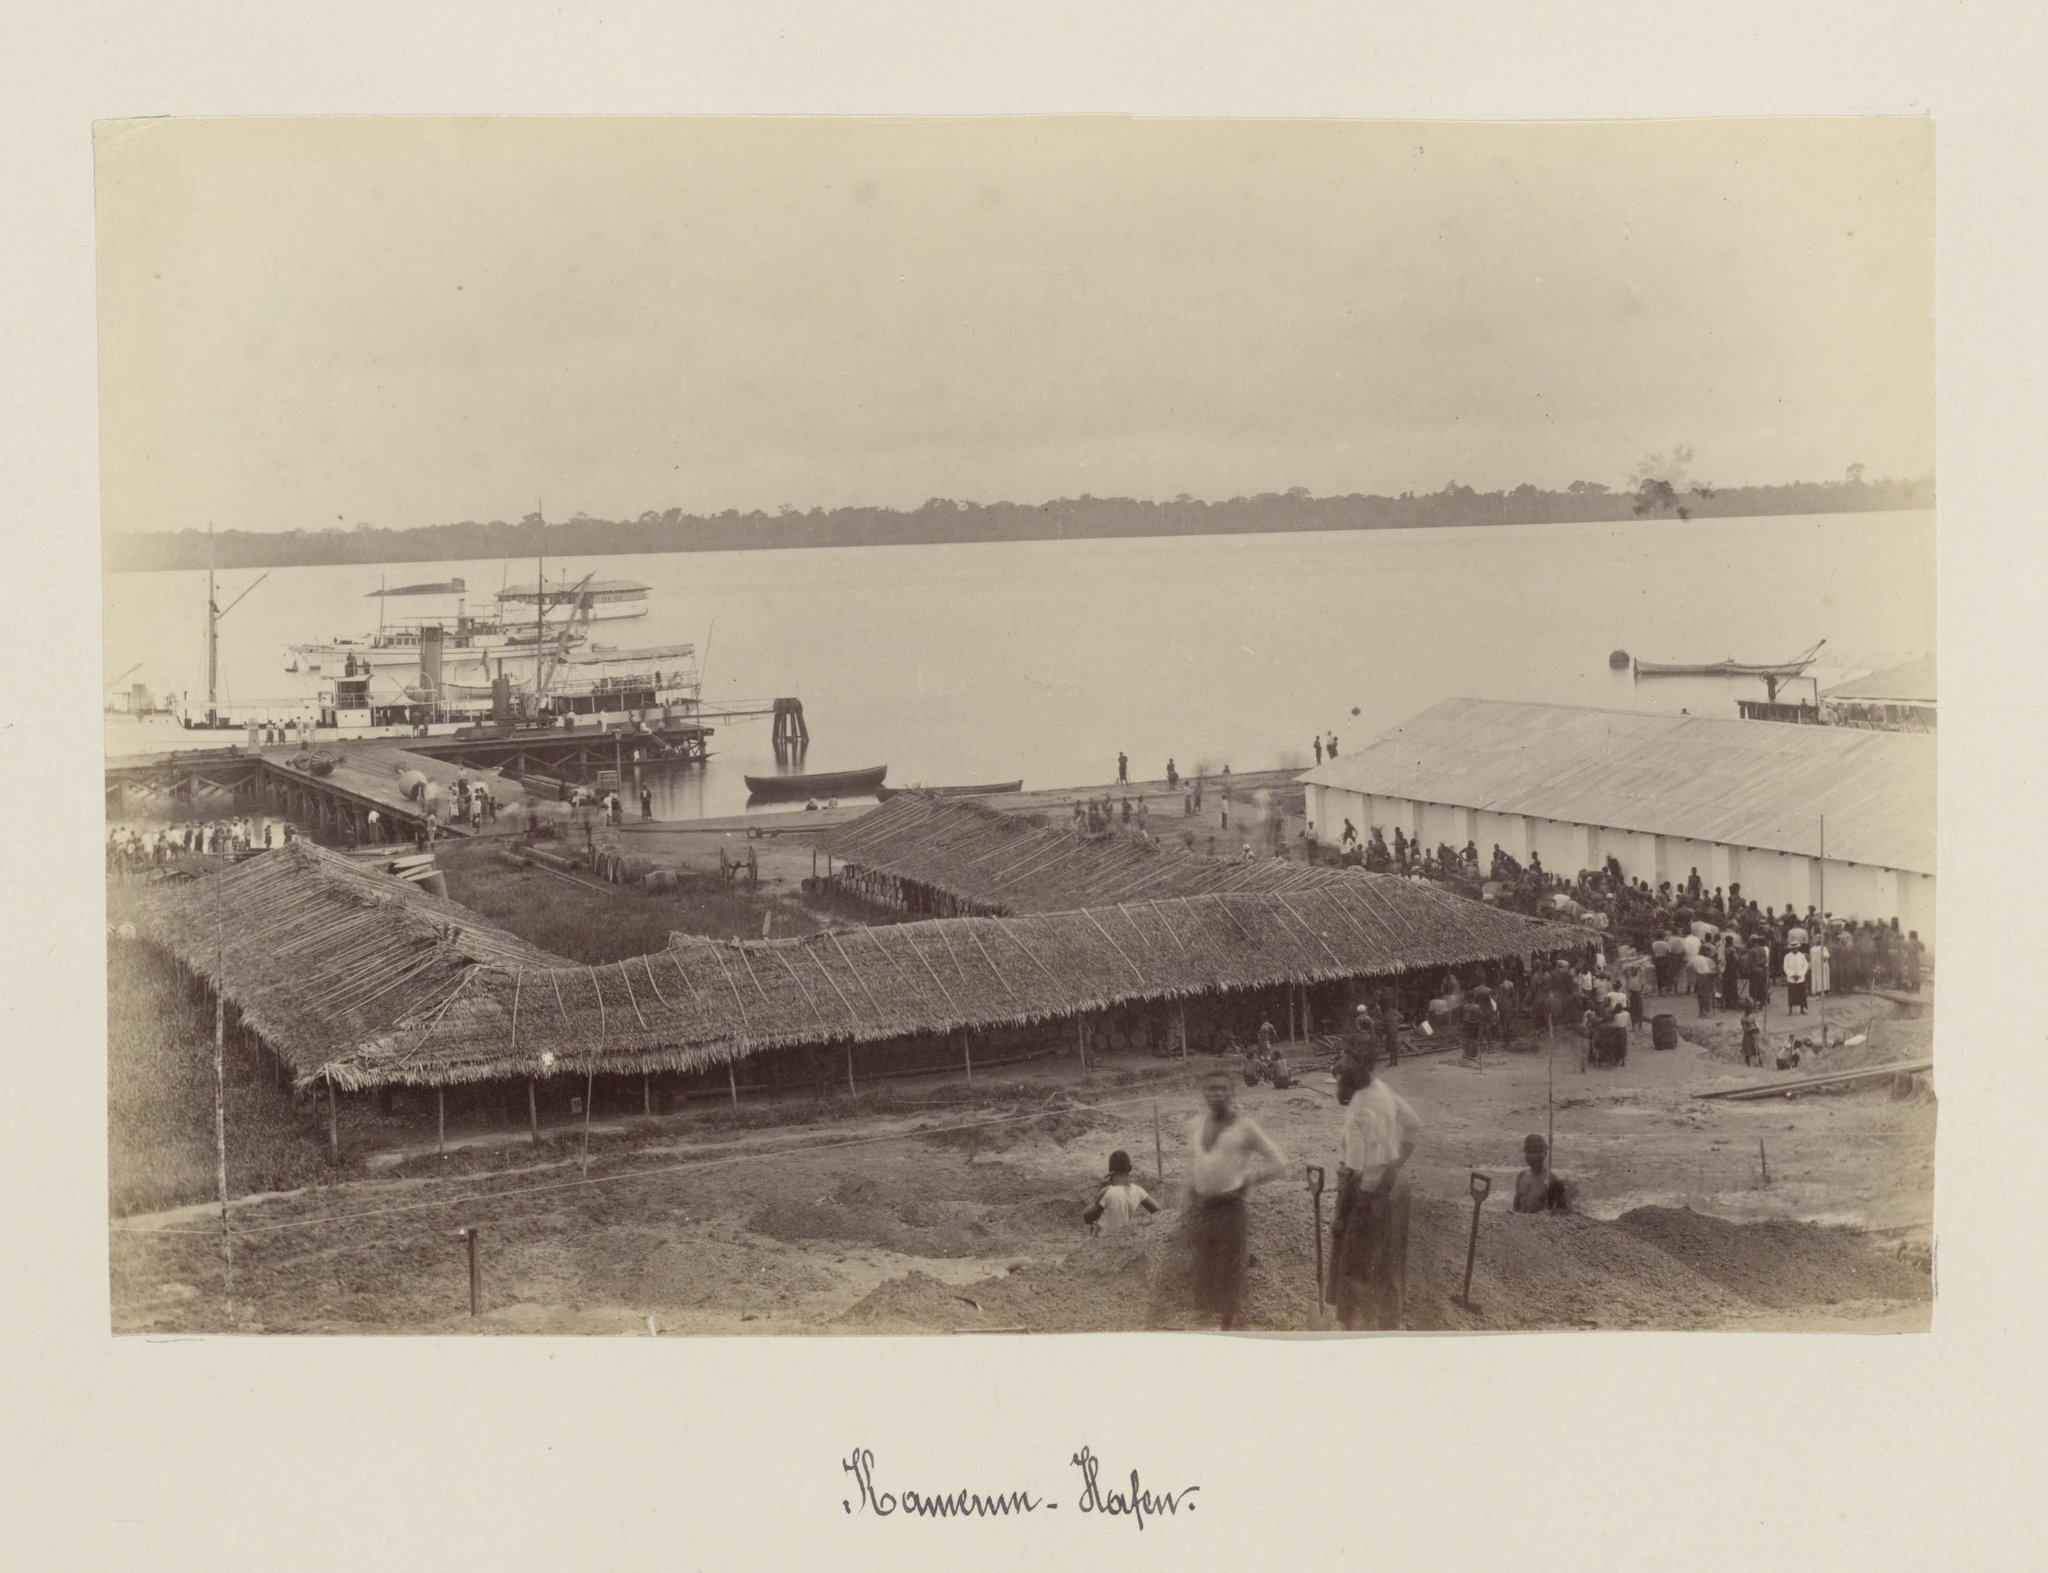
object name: photograph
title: Haven met rieten gebouwen, steiger, schepen en publiek in Kameroen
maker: Anonymous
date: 1899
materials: photographic support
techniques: albumen print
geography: cameroon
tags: harbour (+ view ~ vehicle, ship, etc.)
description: Onderdeel van Fotoalbum met opnames van Kameroen rond 1899.